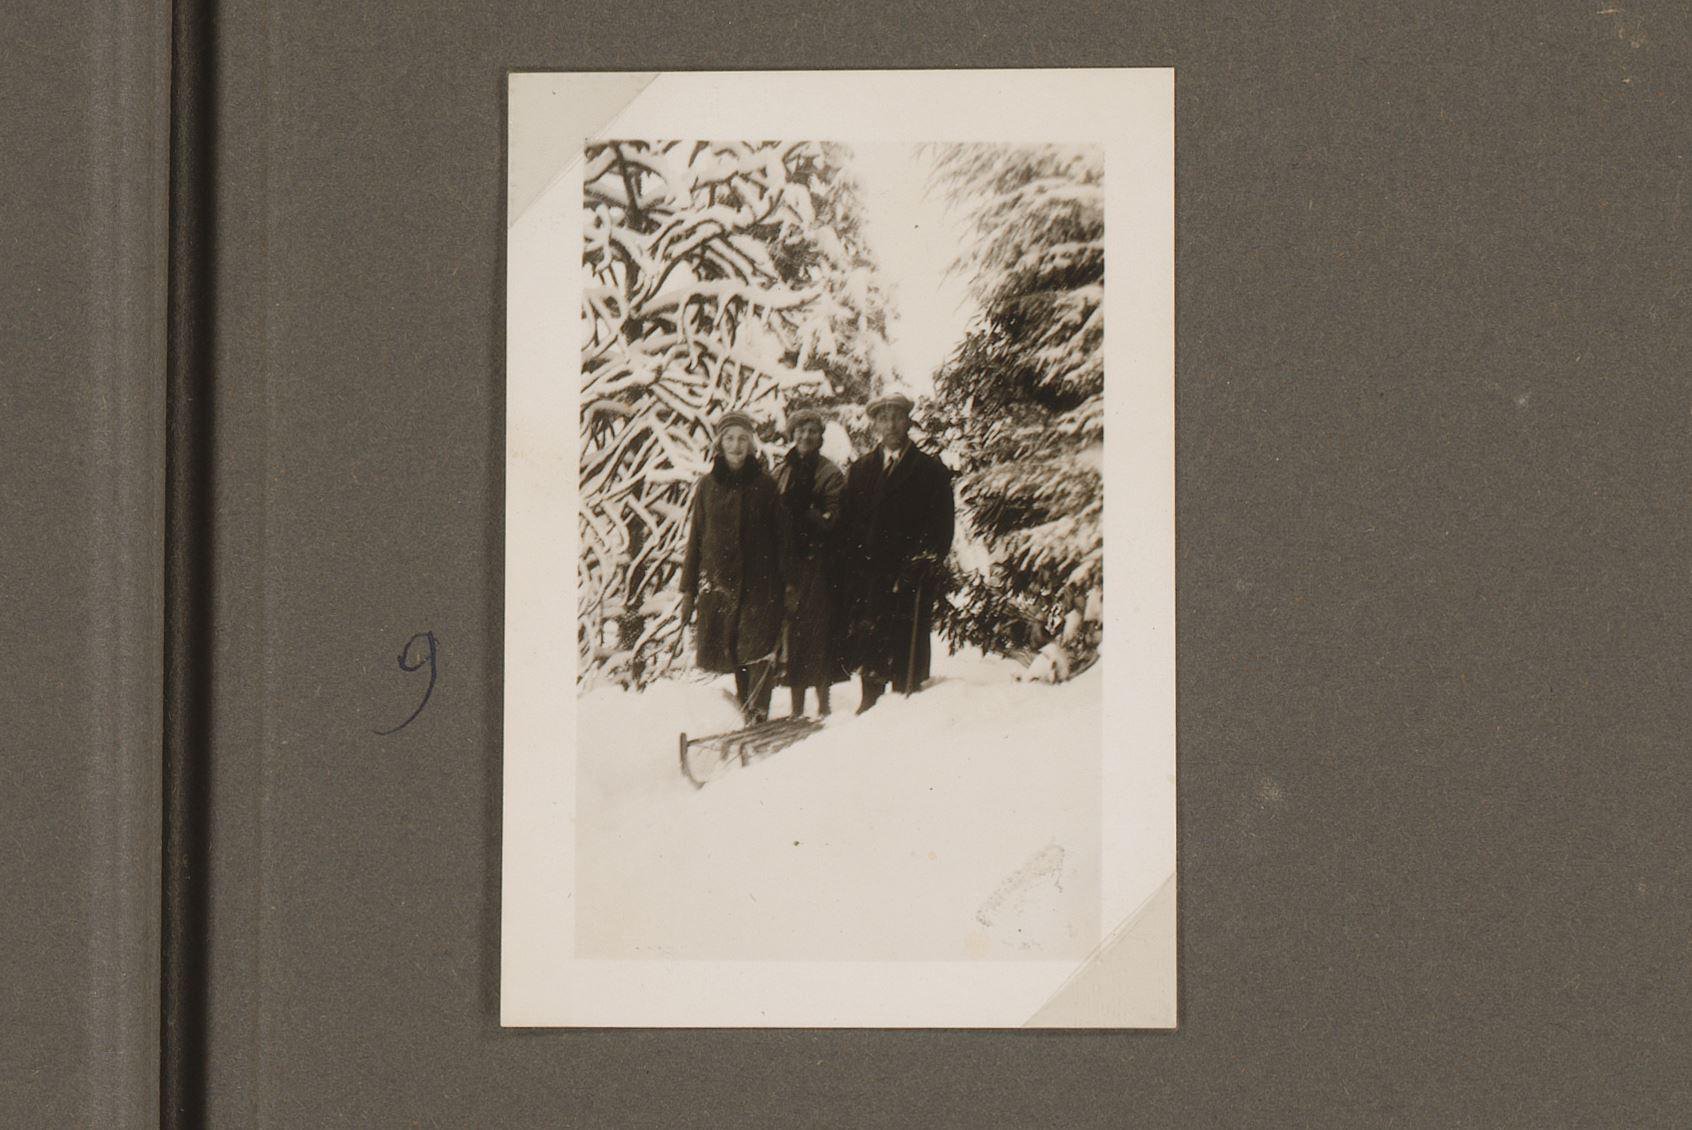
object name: album leaf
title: Familie Streekstra in de tuin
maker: Anonymous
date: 1933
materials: photographic support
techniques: gelatin silver print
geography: ticino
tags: family group, especially parents with their child(ren), garden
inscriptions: number: ‘9’